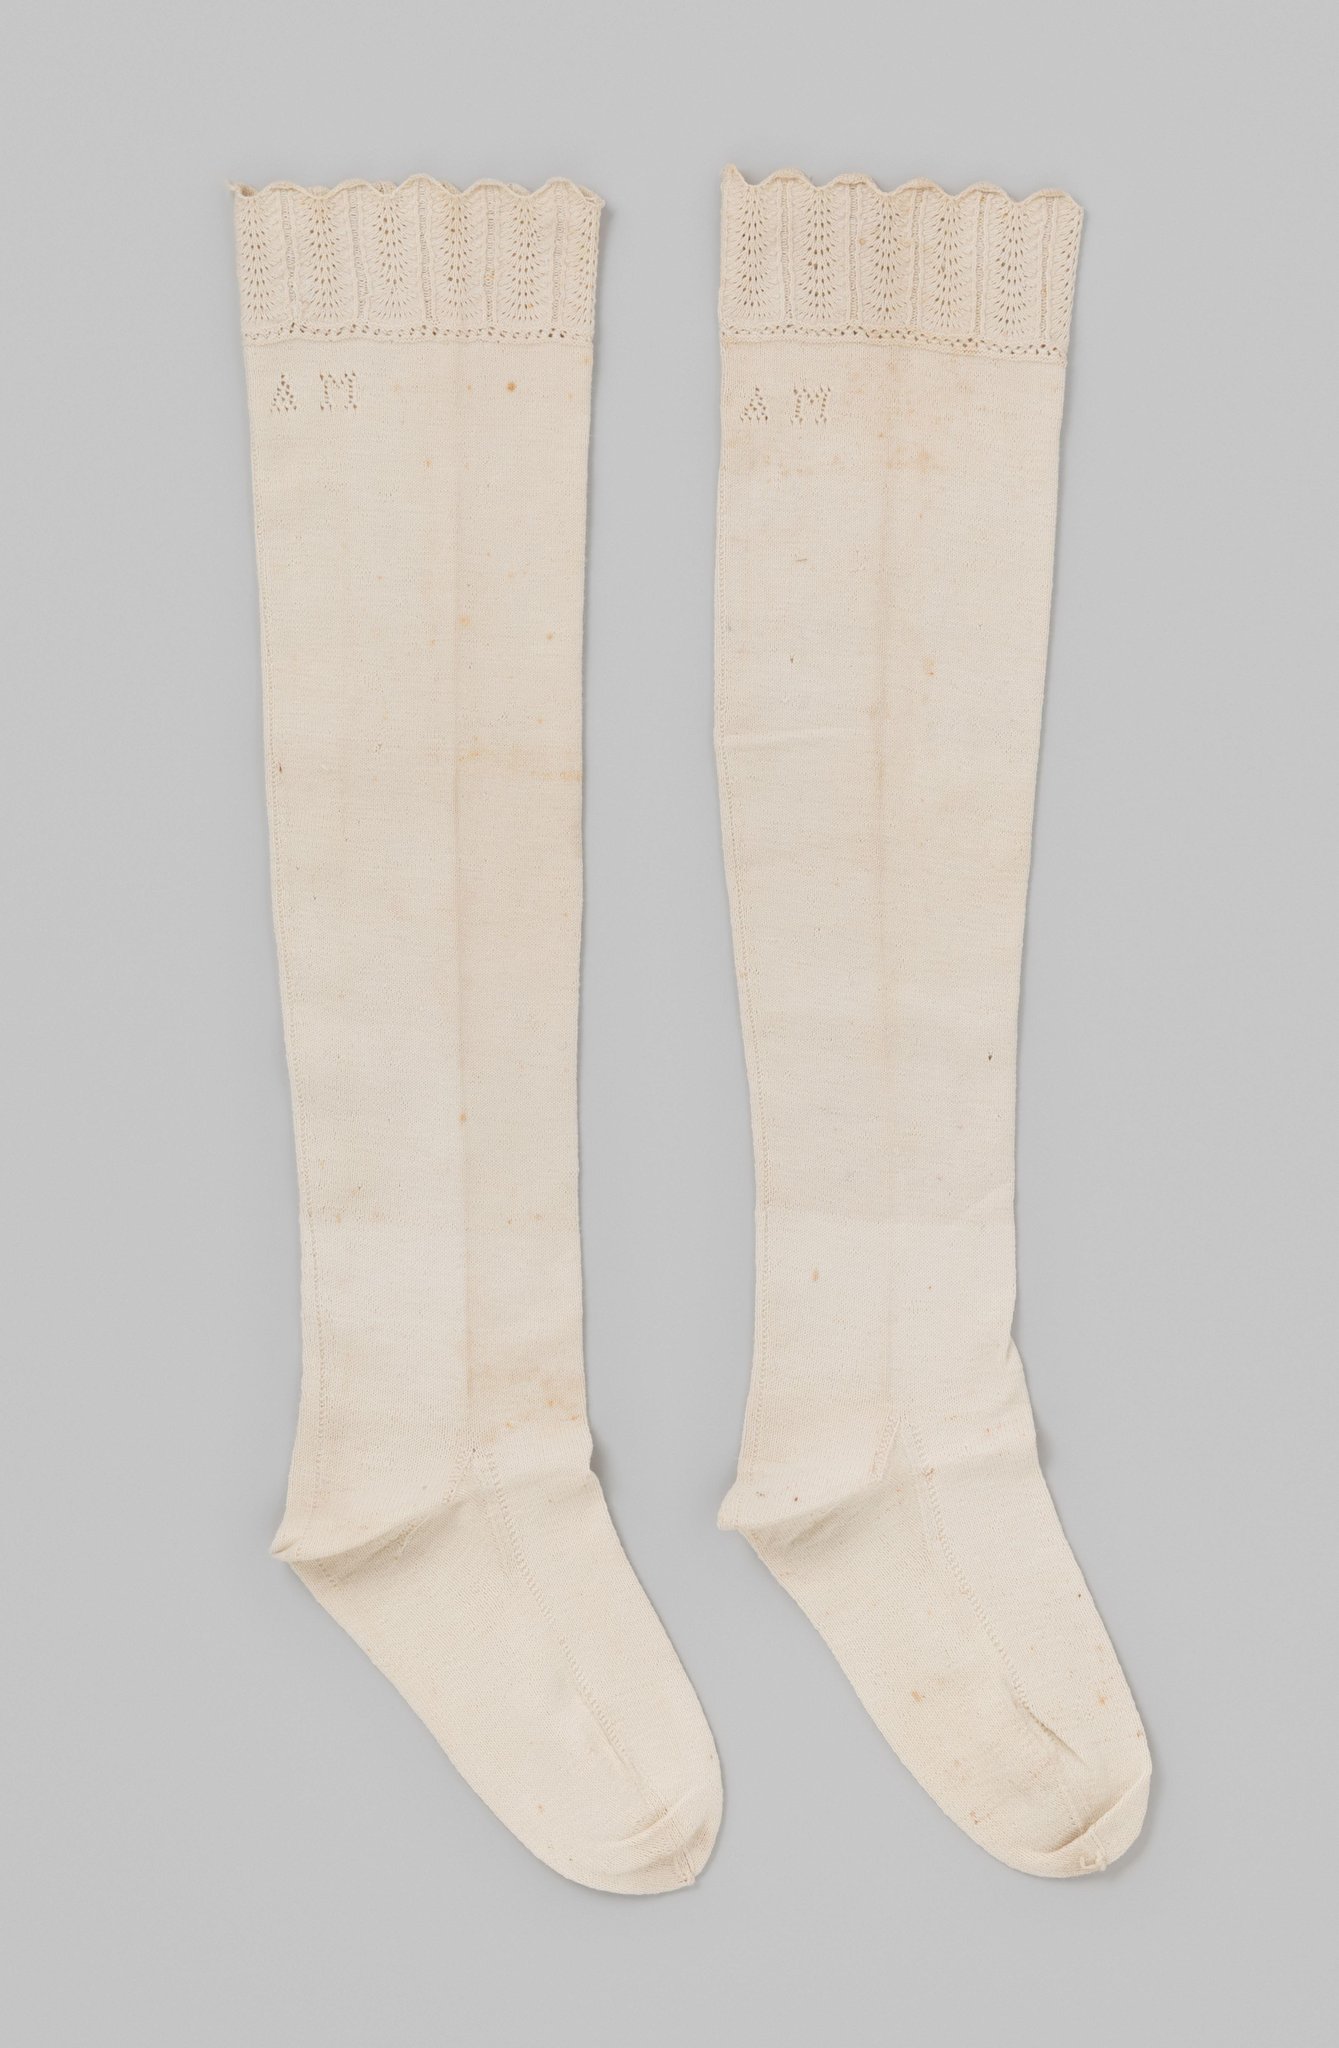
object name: childrenswear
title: Kous van effen witte katoenen tricot, met boord van ajour pauwenverenmotief en geschulpte rand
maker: Anonymous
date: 1830-1840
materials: cotton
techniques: embroidery, knitting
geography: netherlands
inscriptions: initials: ‘'A M'’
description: Kous van effen witte katoenen tricot, met boord van ajour pauwenverenmotief in verticale banen en geschulpte rand. Naad middenachter. Gemerkt met initialen in ajour: 'A M'.